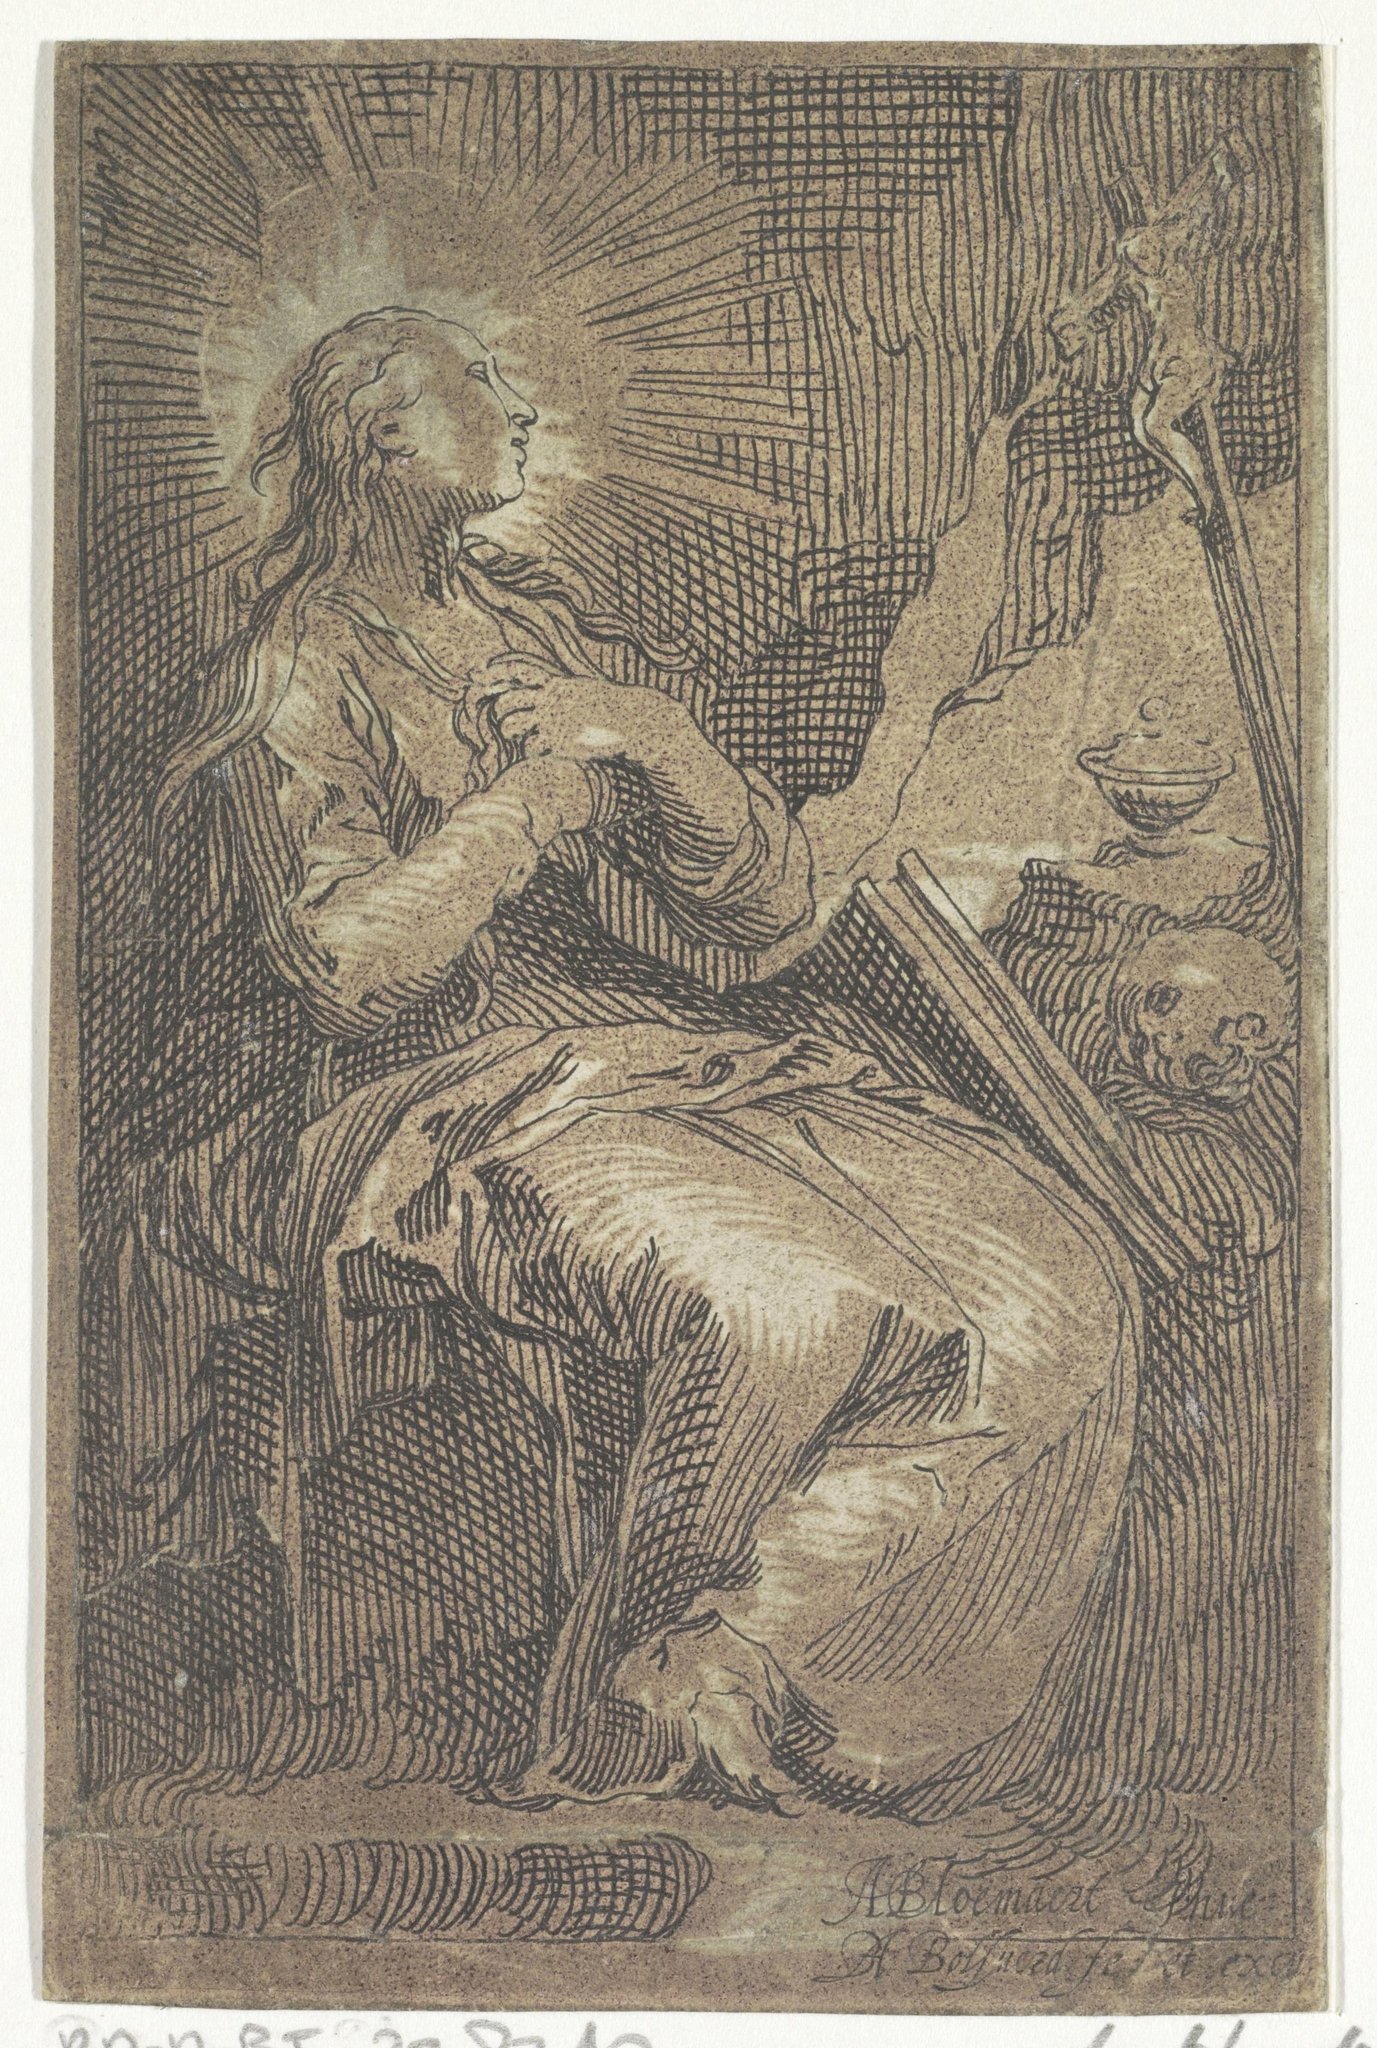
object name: print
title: Boetvaardige Maria Magdalena in de grot voor crucifix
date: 1610-1615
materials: paper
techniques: woodcut, etching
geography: netherlands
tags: the penitent harlot mary magdalene; possible attributes: book (or scroll), crown, crown of thorns, crucifix, jar of ointment, mirror, musical instrument, palm-branch, rosary, scourge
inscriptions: collector's mark: Lugt 240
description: Er zijn drie verschillende platen met dezelfde voostelling gemaakt. Dit is de tweede staat van plaat B.